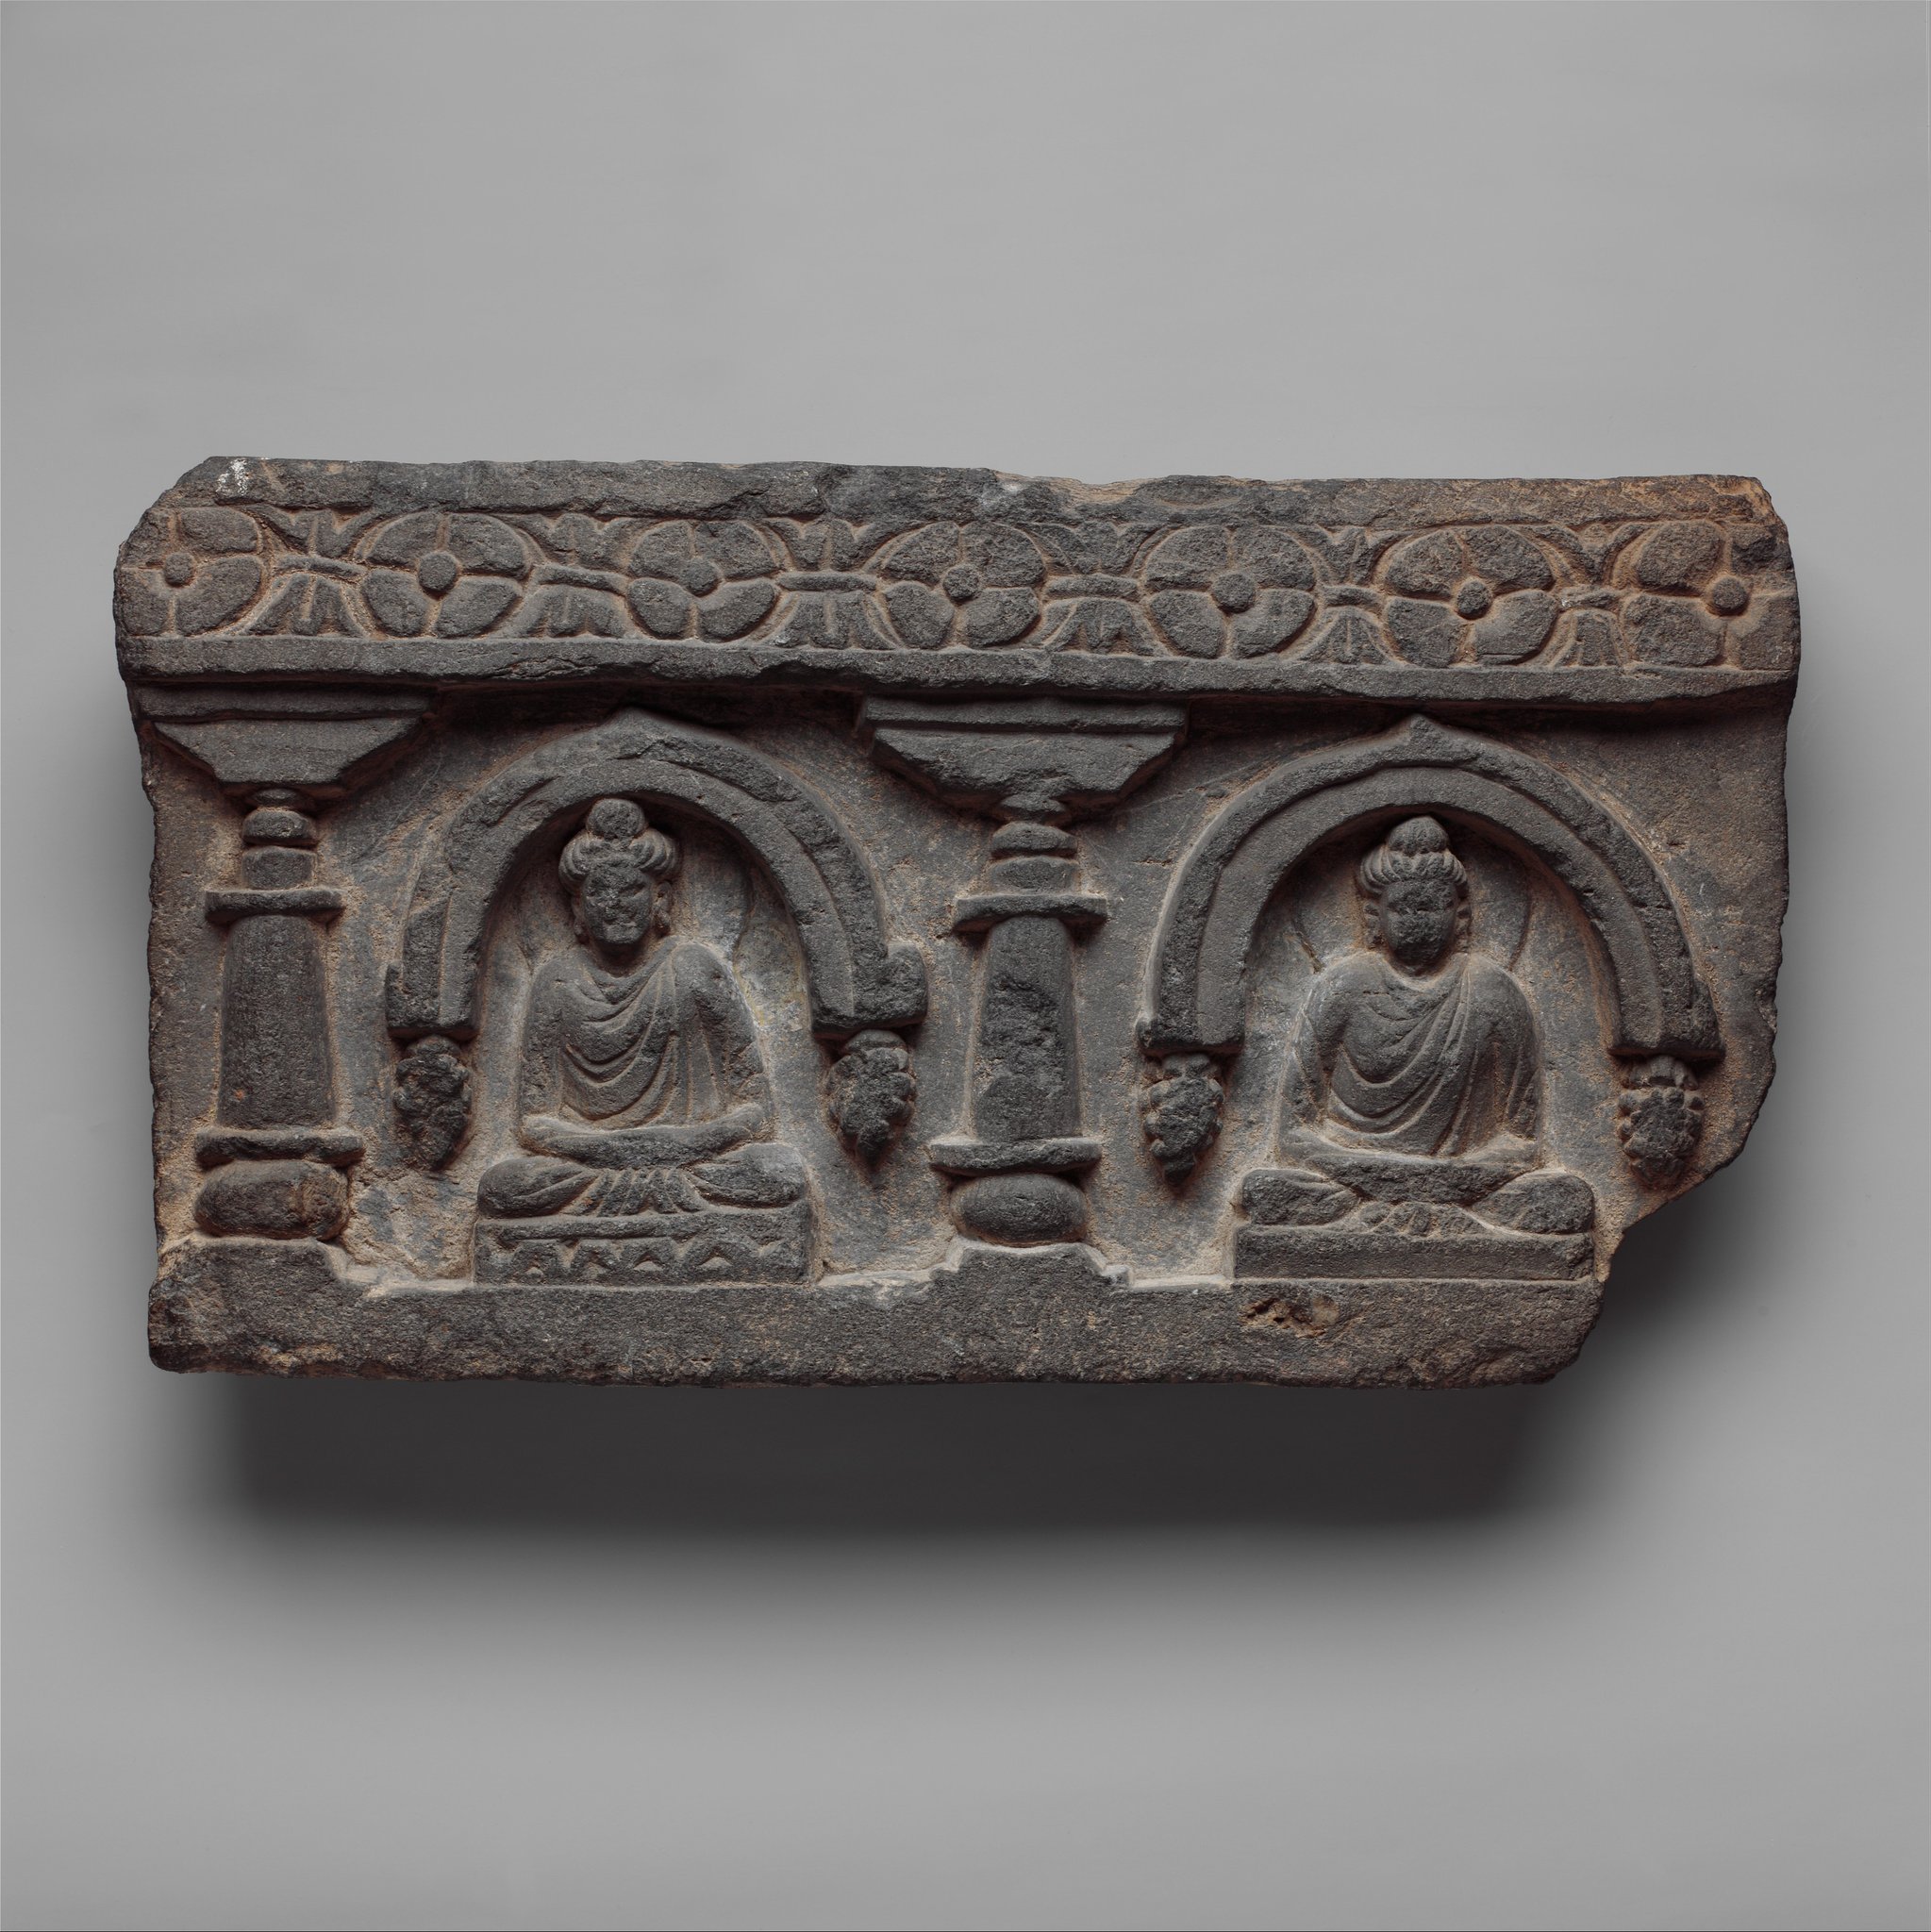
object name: relief fragment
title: Frieze with Two Seated Buddhas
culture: gandhara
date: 101-300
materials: stone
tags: gandhara,buddha